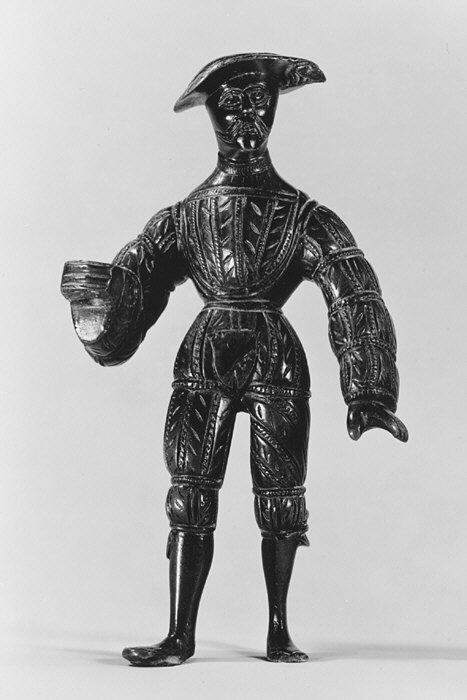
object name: statuette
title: Two Landsknechts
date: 1534-1566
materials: bronze, lacquer, patina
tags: soldiers